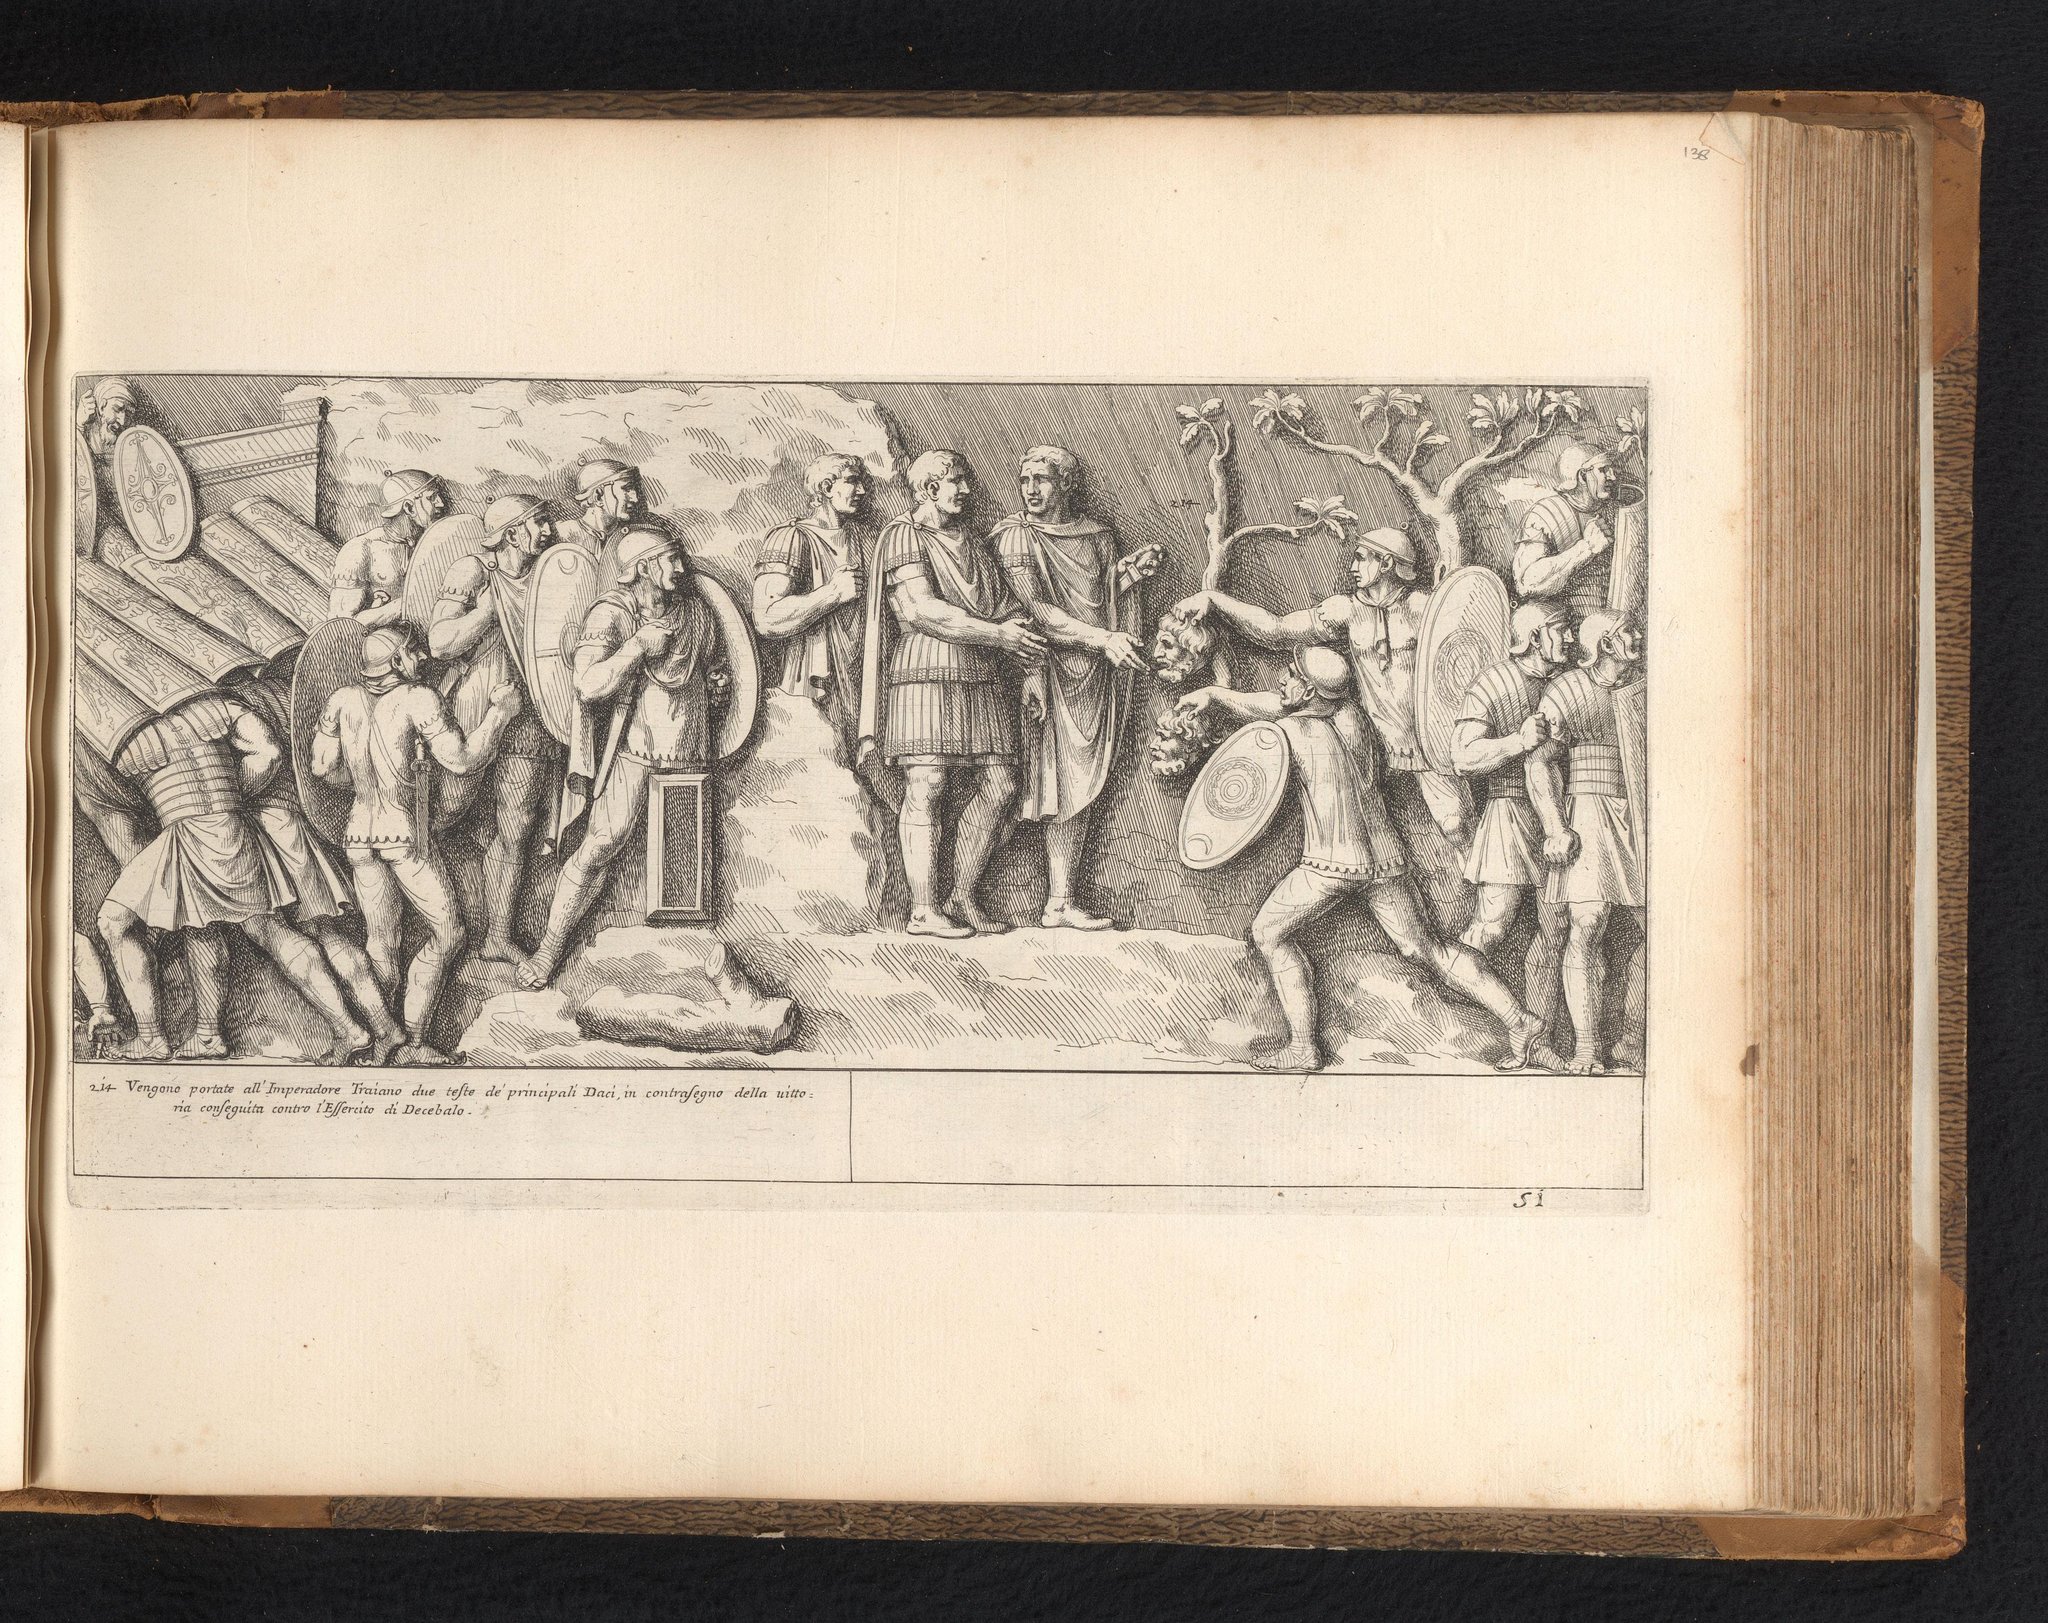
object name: print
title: Zuil van Trajanus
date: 1637-1691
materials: paper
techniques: etching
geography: rome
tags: triumphal column with helical friezes, piece of sculpture, reproduction of a piece of sculpture, the soldier; the soldier's life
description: Detail van het spiraalvormige gebeeldhouwde fries op de Zuil van Trajanus. Het fries toont de oorlogen tussen de Romeinen en de Daciërs. Verklarende nummers in de ondermarge. Prent maakt deel uit van een album.